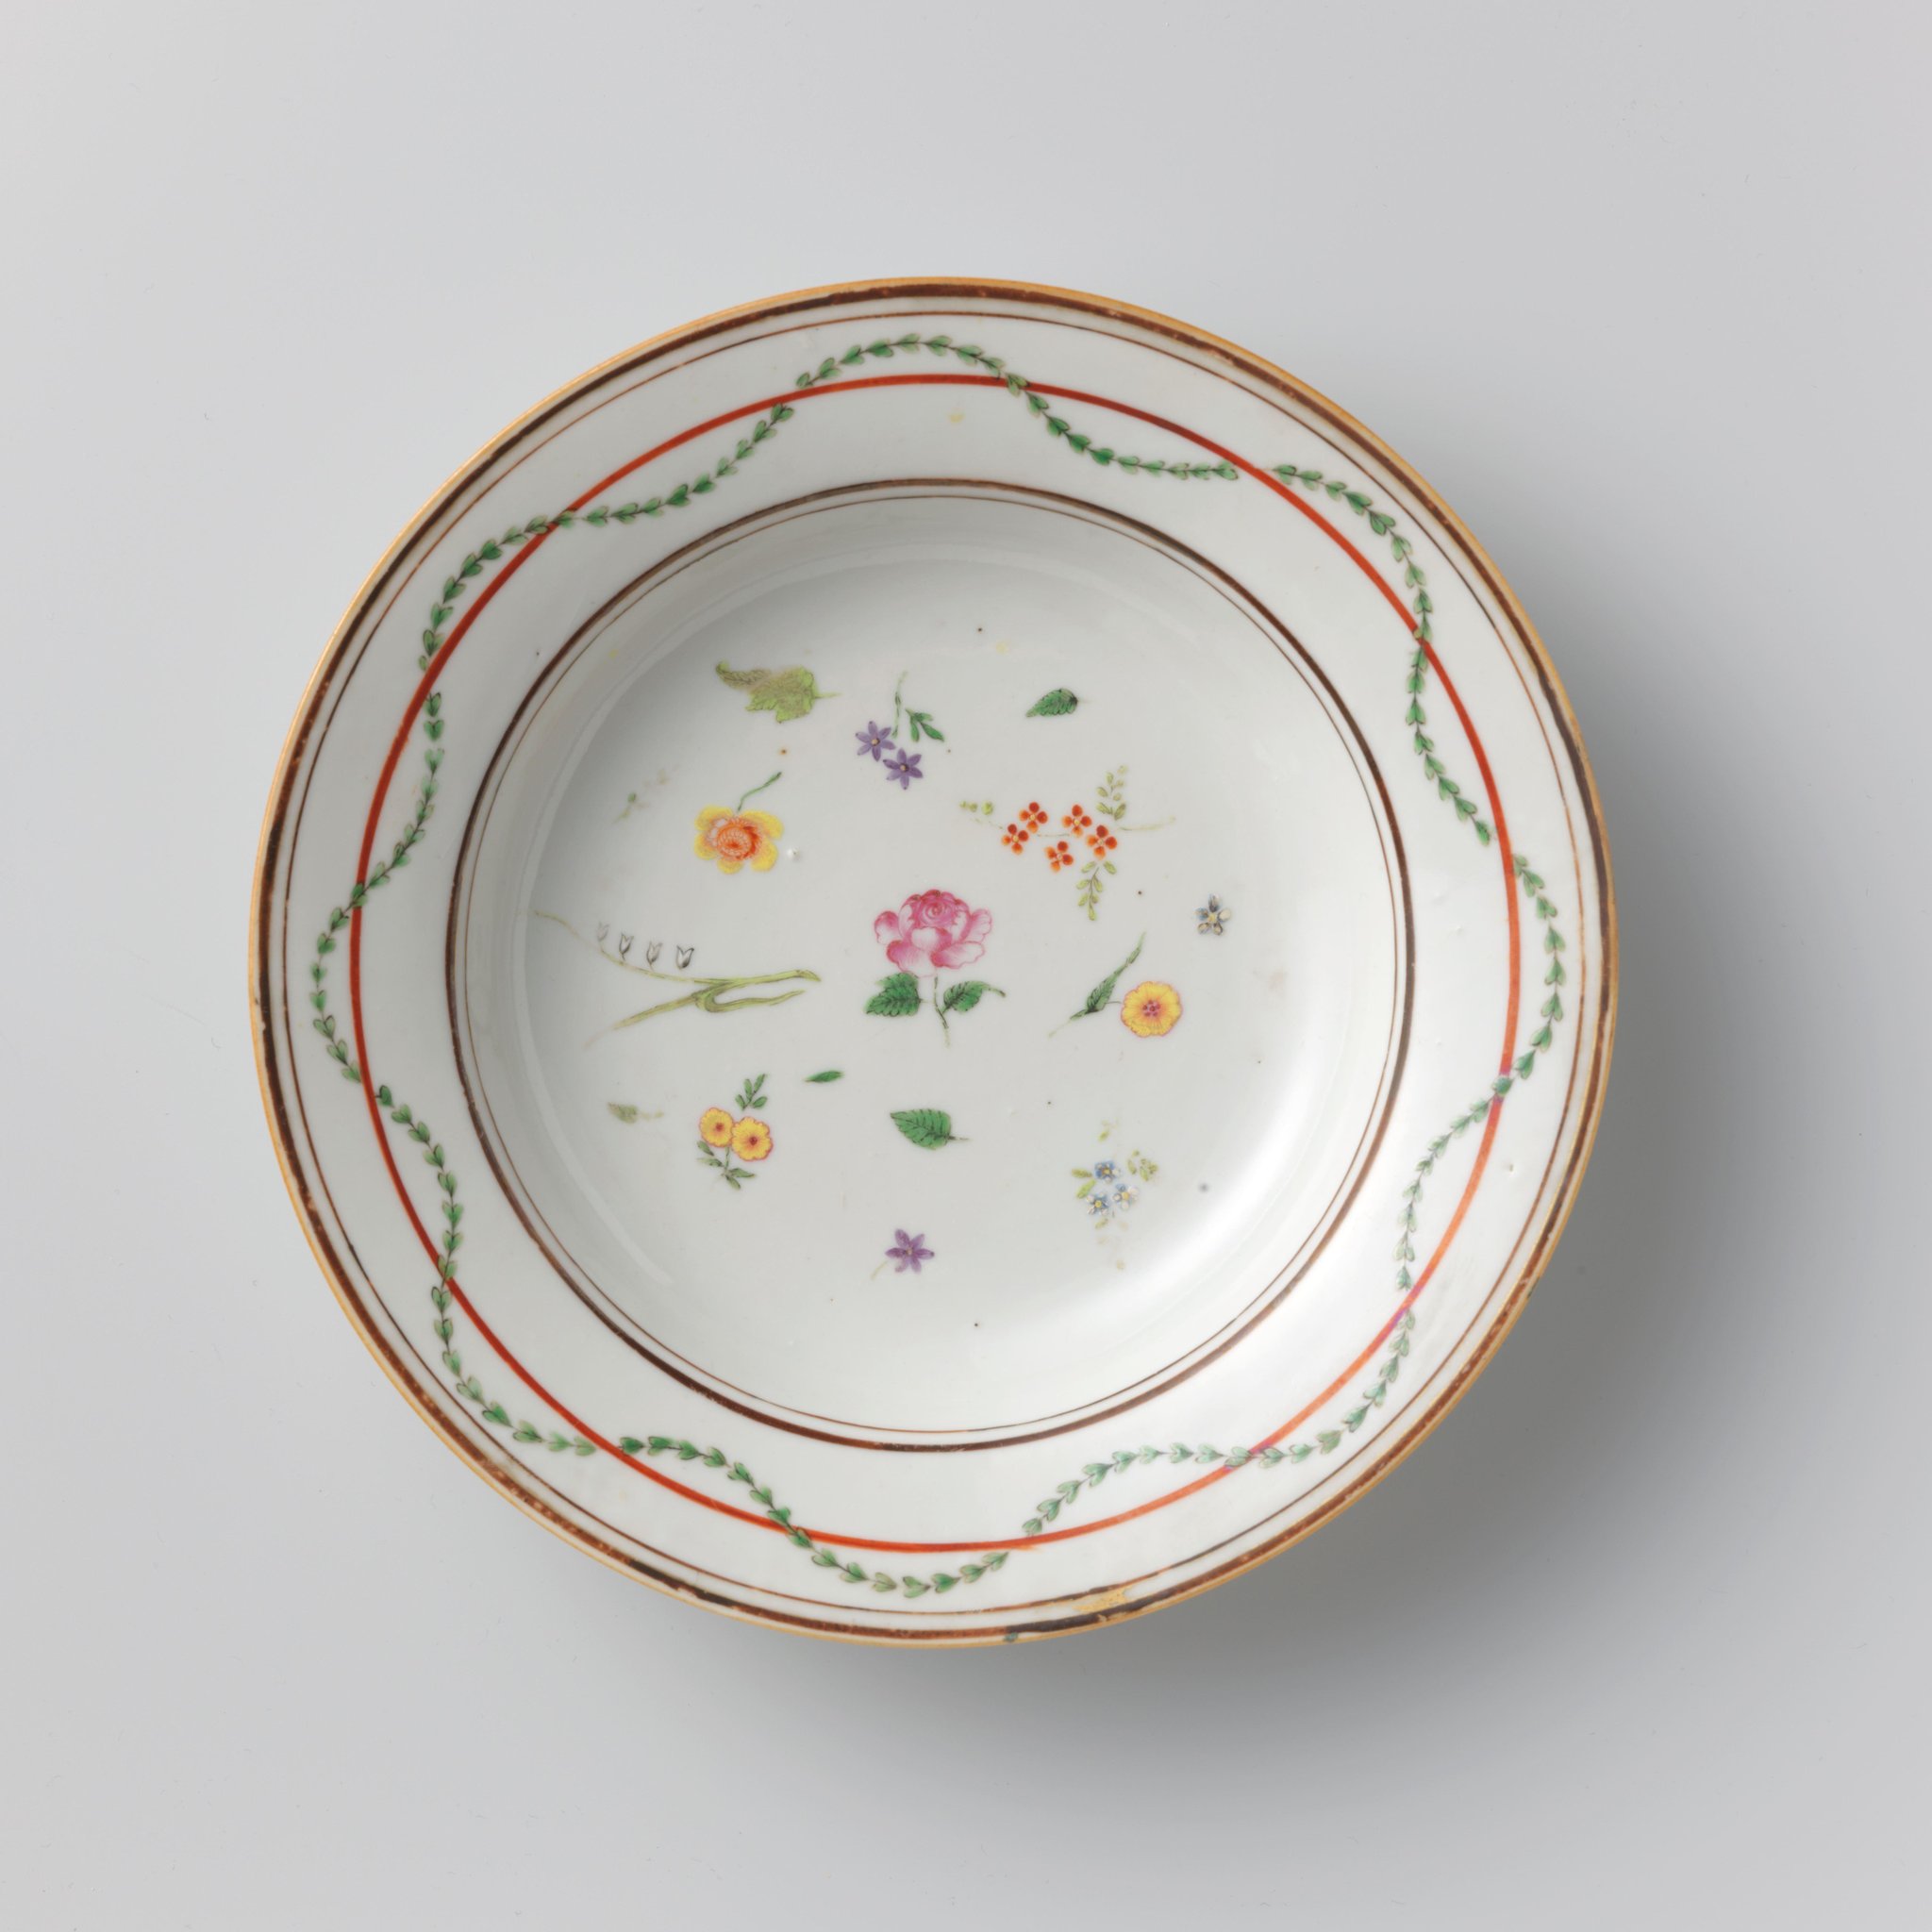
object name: plate dish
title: Soup plate with scattered flowers and a chain border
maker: Anonymous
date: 1775-1799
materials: glaze, gold, paint, porcelain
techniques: firing, gilding, turning, vitrification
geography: china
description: Soepbord van porselein, beschilderd op het glazuur in blauw, rood, roze, groen, geel, zwart en goud. Op het plat losse bloemen; de rand met een decoratieve band met een rode ring en daaromheen golvende bladerrank. Famille rose.